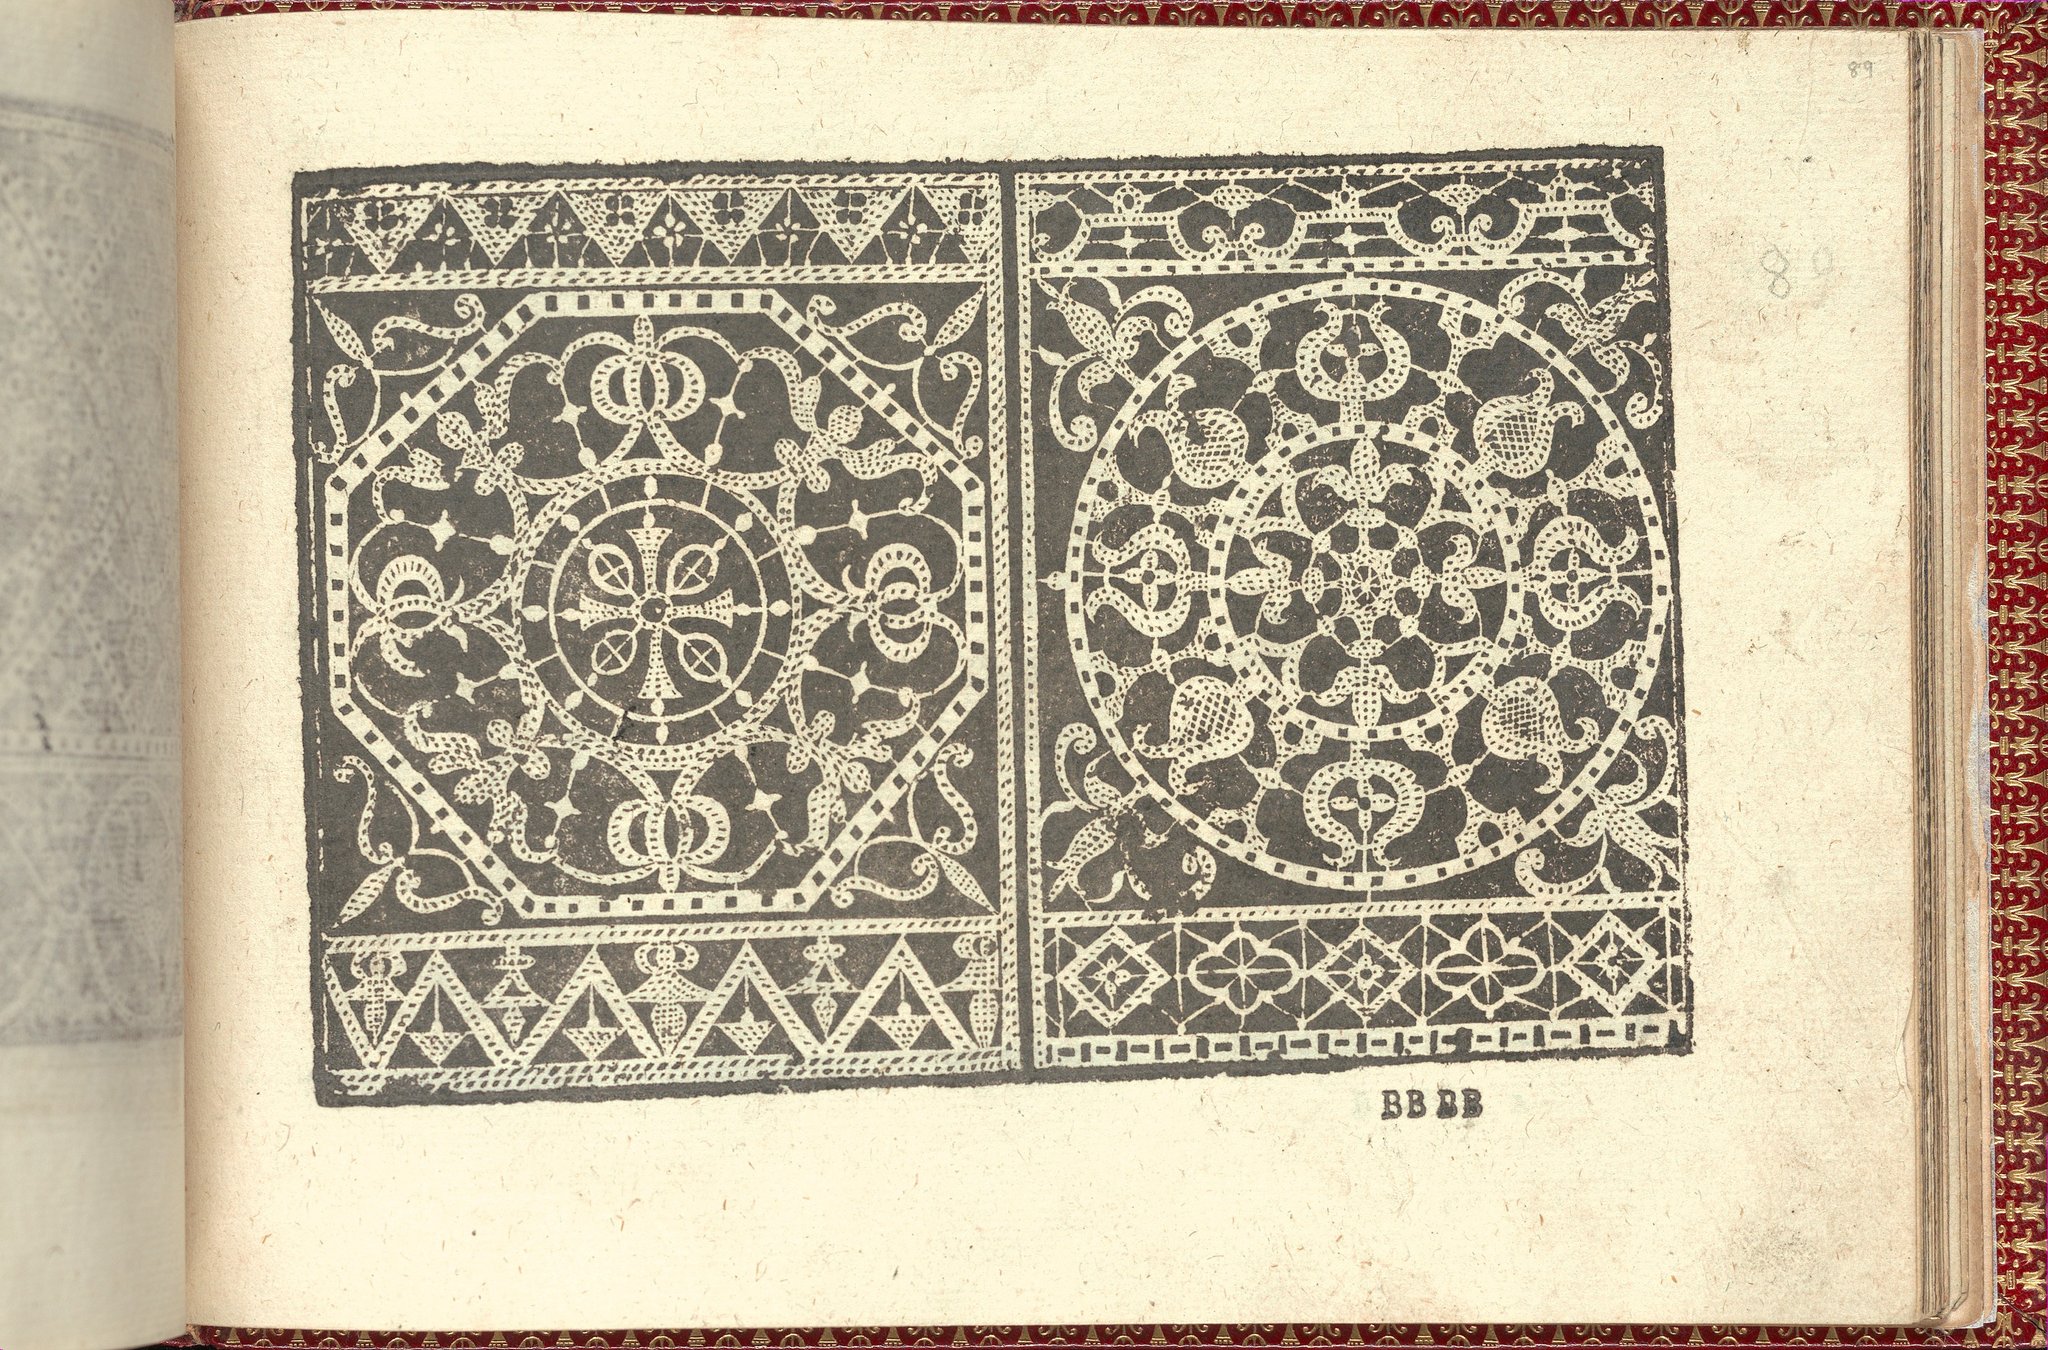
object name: book print ornament architecture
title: Corona delle Nobili et Virtuose Donne: Libro I-IV, page 89 (recto)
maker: cesare vecellio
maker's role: publisher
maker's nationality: italian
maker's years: 1521-1601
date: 1601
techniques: woodcut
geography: italy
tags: ornament